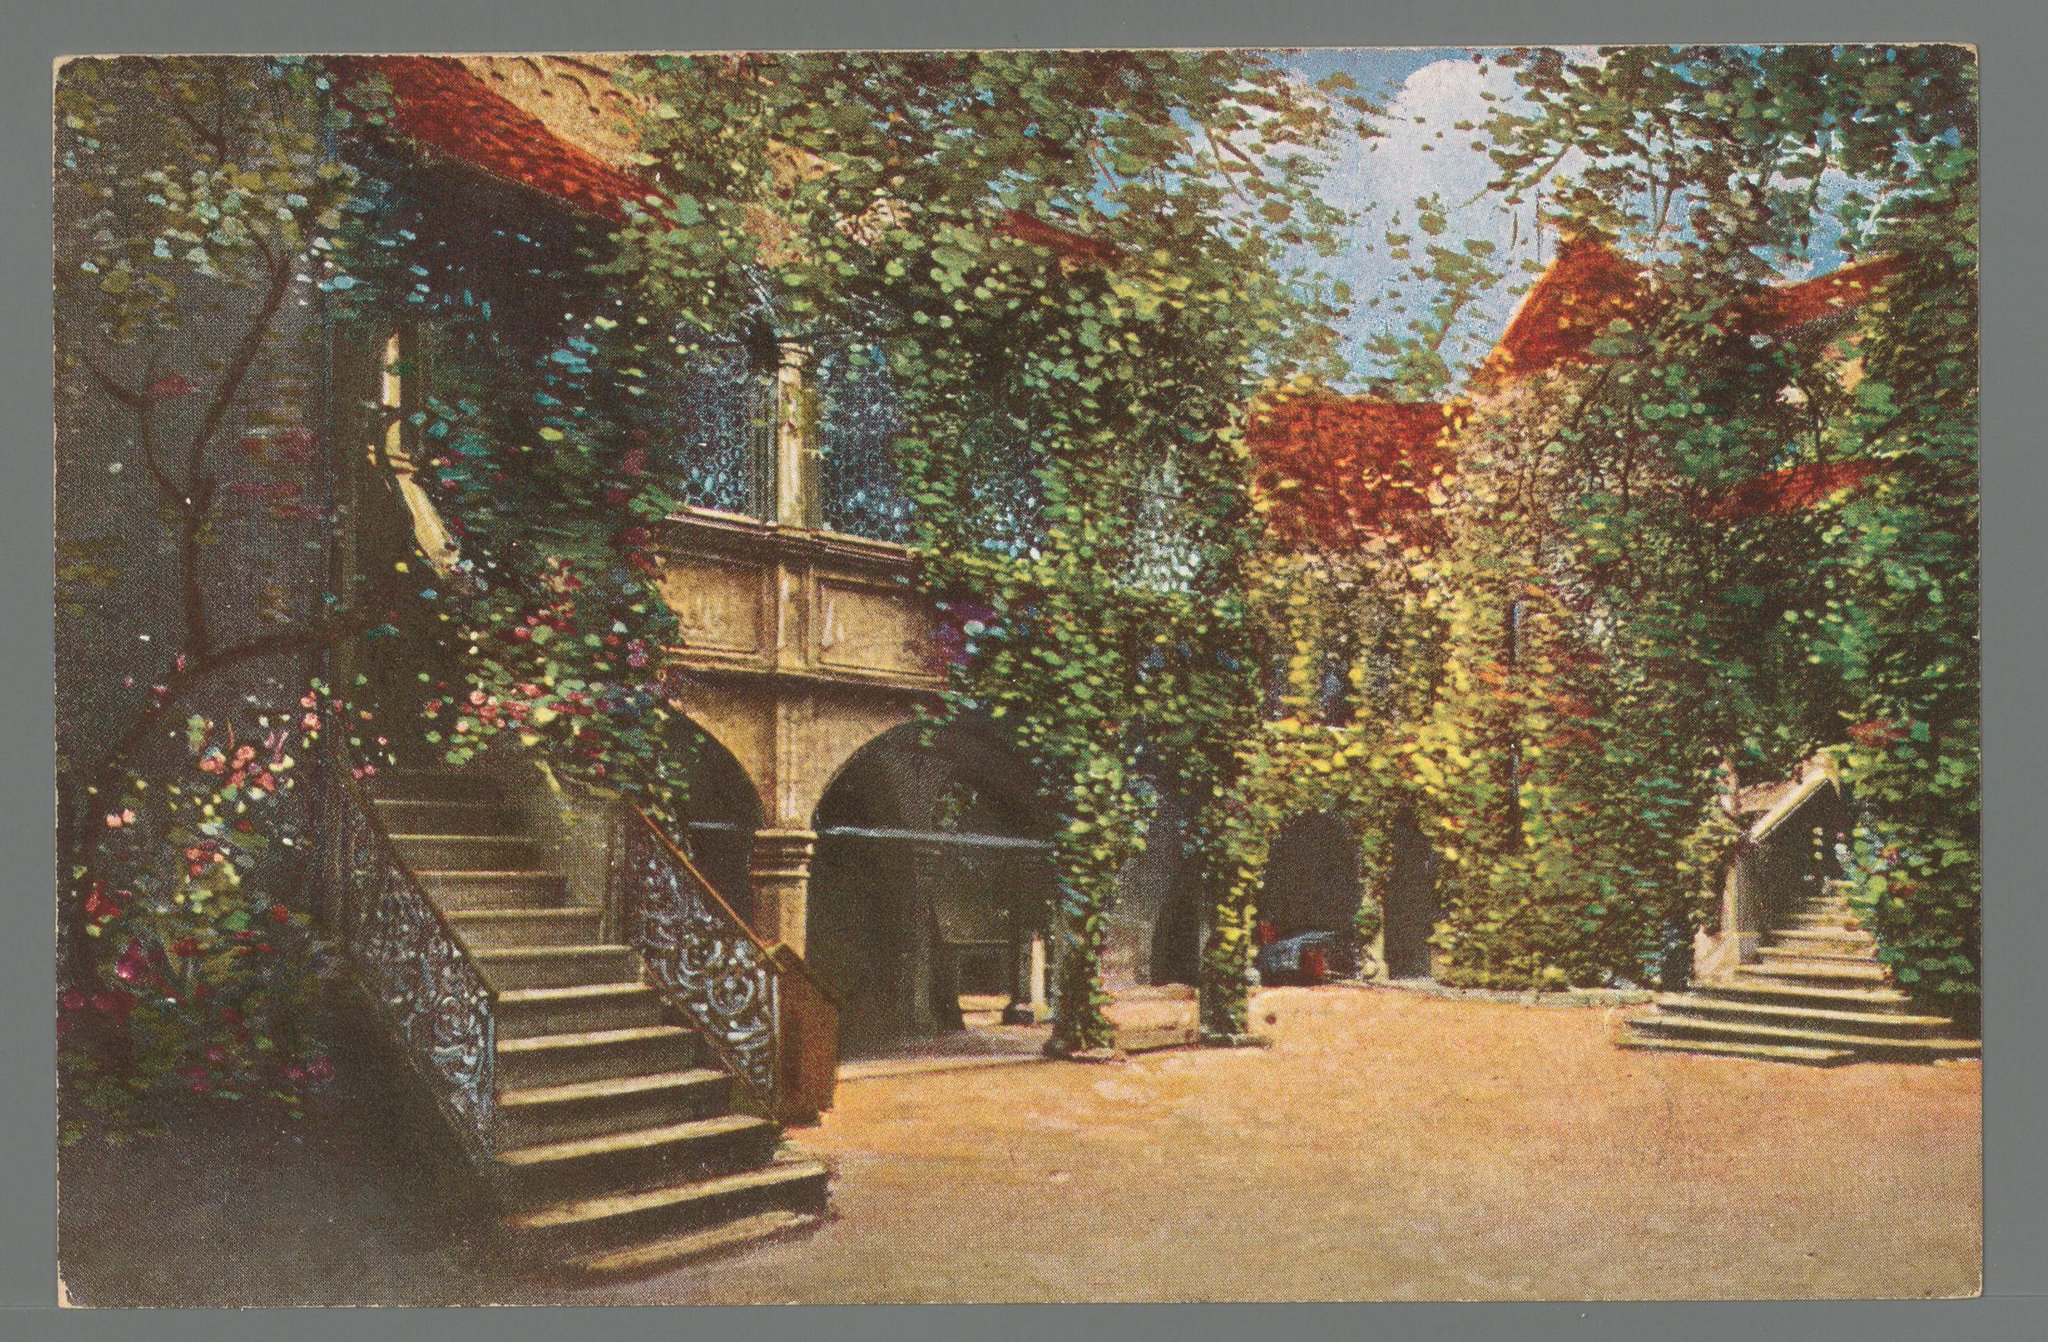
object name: ansichtkaart, prentbriefkaart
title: Schlosshof von Rubein (Obermais)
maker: Anonymous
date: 1905-1929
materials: cardboard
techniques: four-color autotype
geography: munich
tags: plants; vegetation, inner court of palace or 'hôtel'